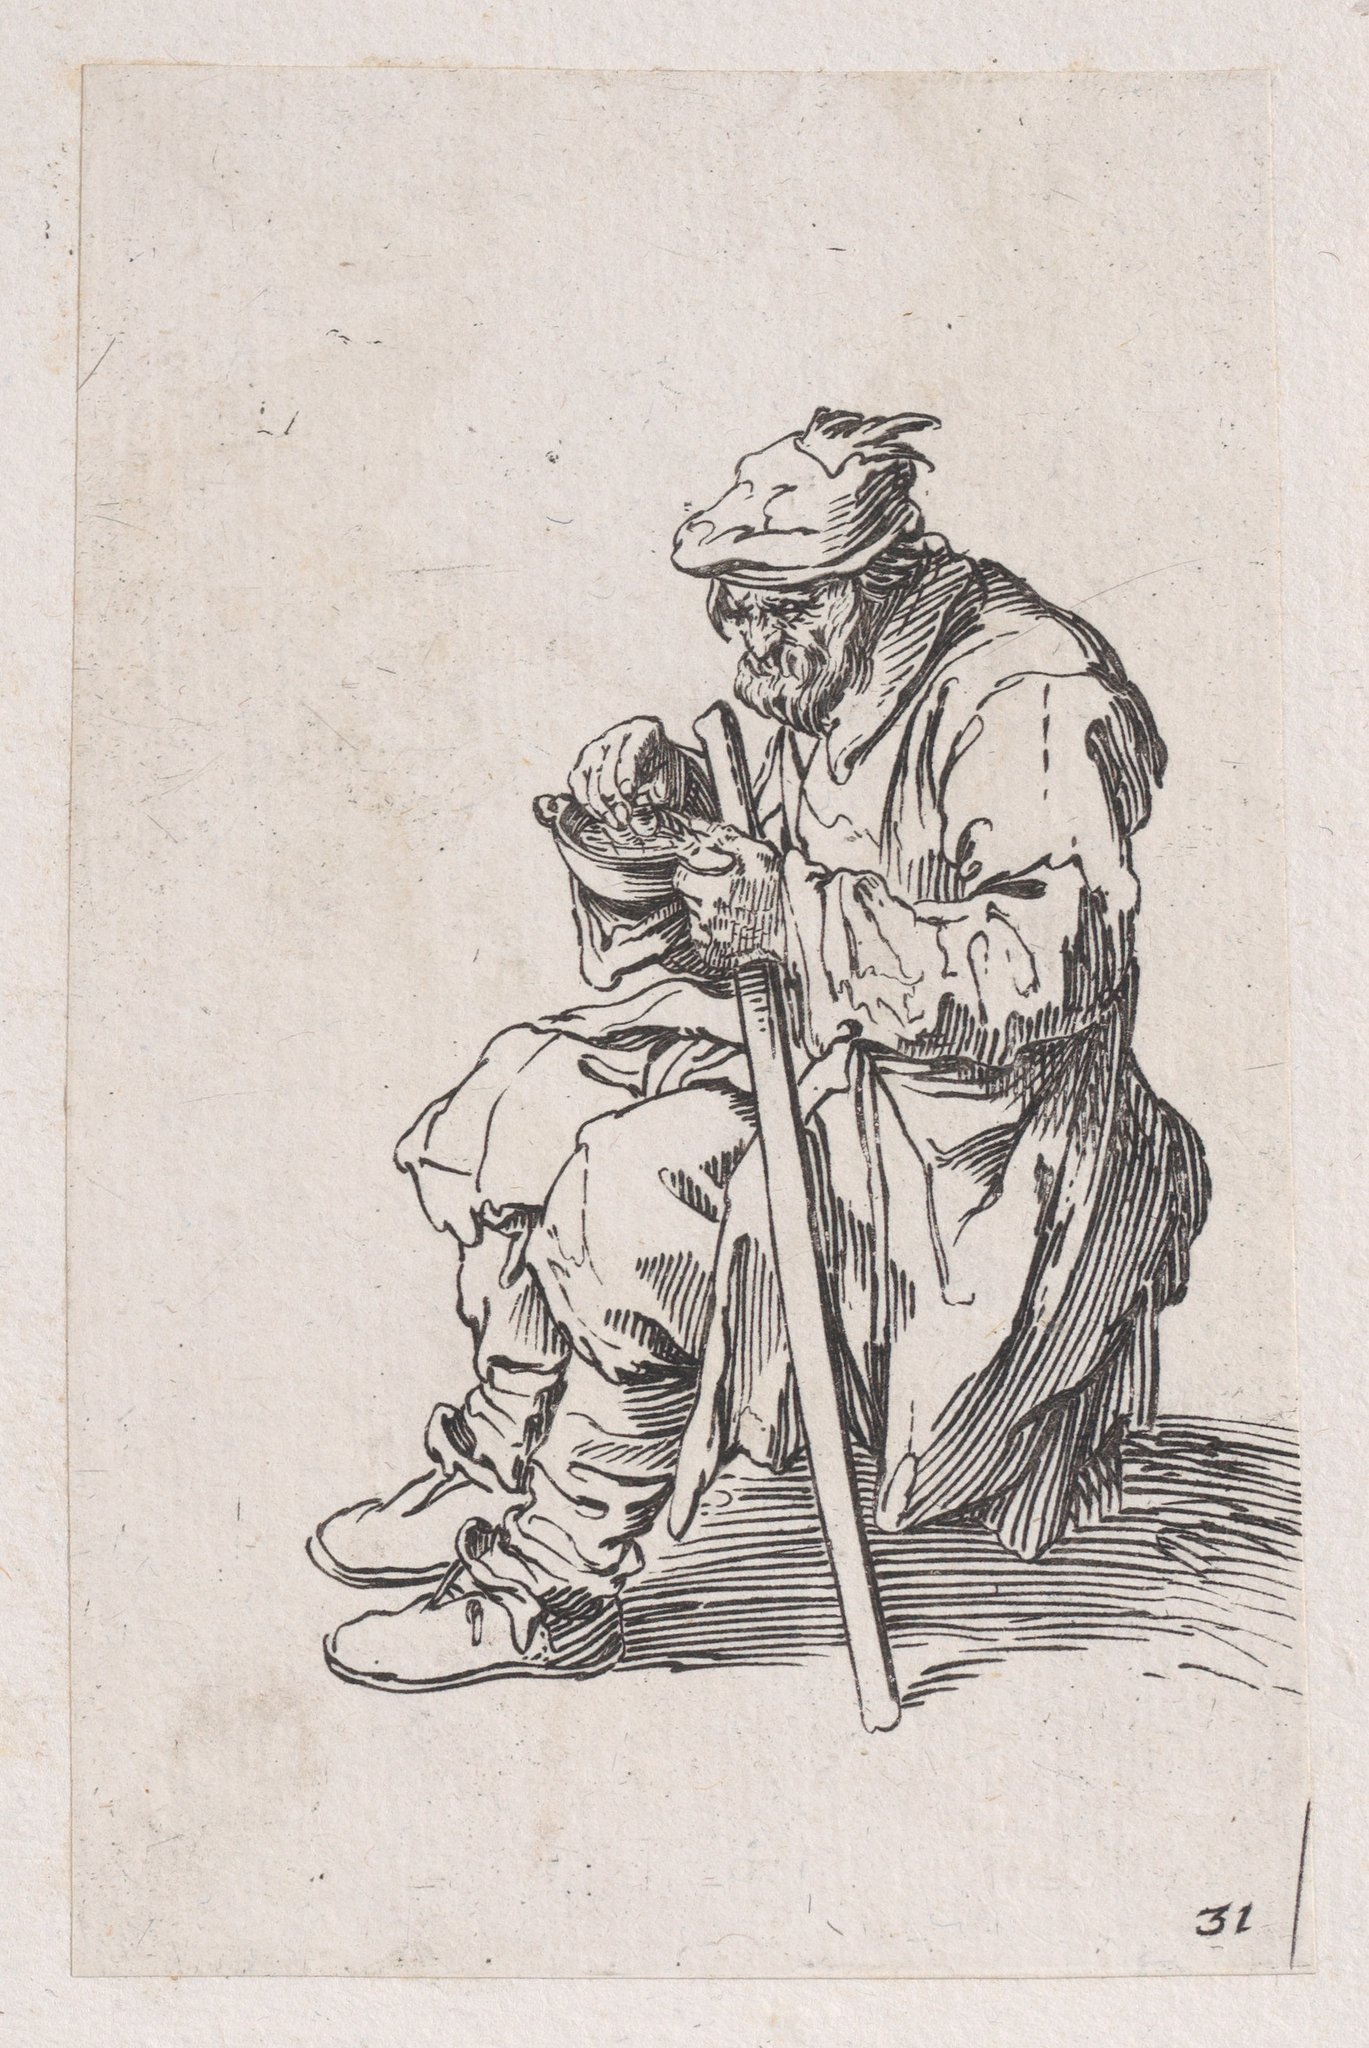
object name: print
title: Reverse Copy of Le Gueux Assis et Mangeant (The Beggar Sitting and Eating), from Les Gueux suite appelée aussi Les Mendiants, Les Baroni, ou Les Barons (The Beggars, also called the Barons)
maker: Anonymous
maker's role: artist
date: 1601-1700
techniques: etching